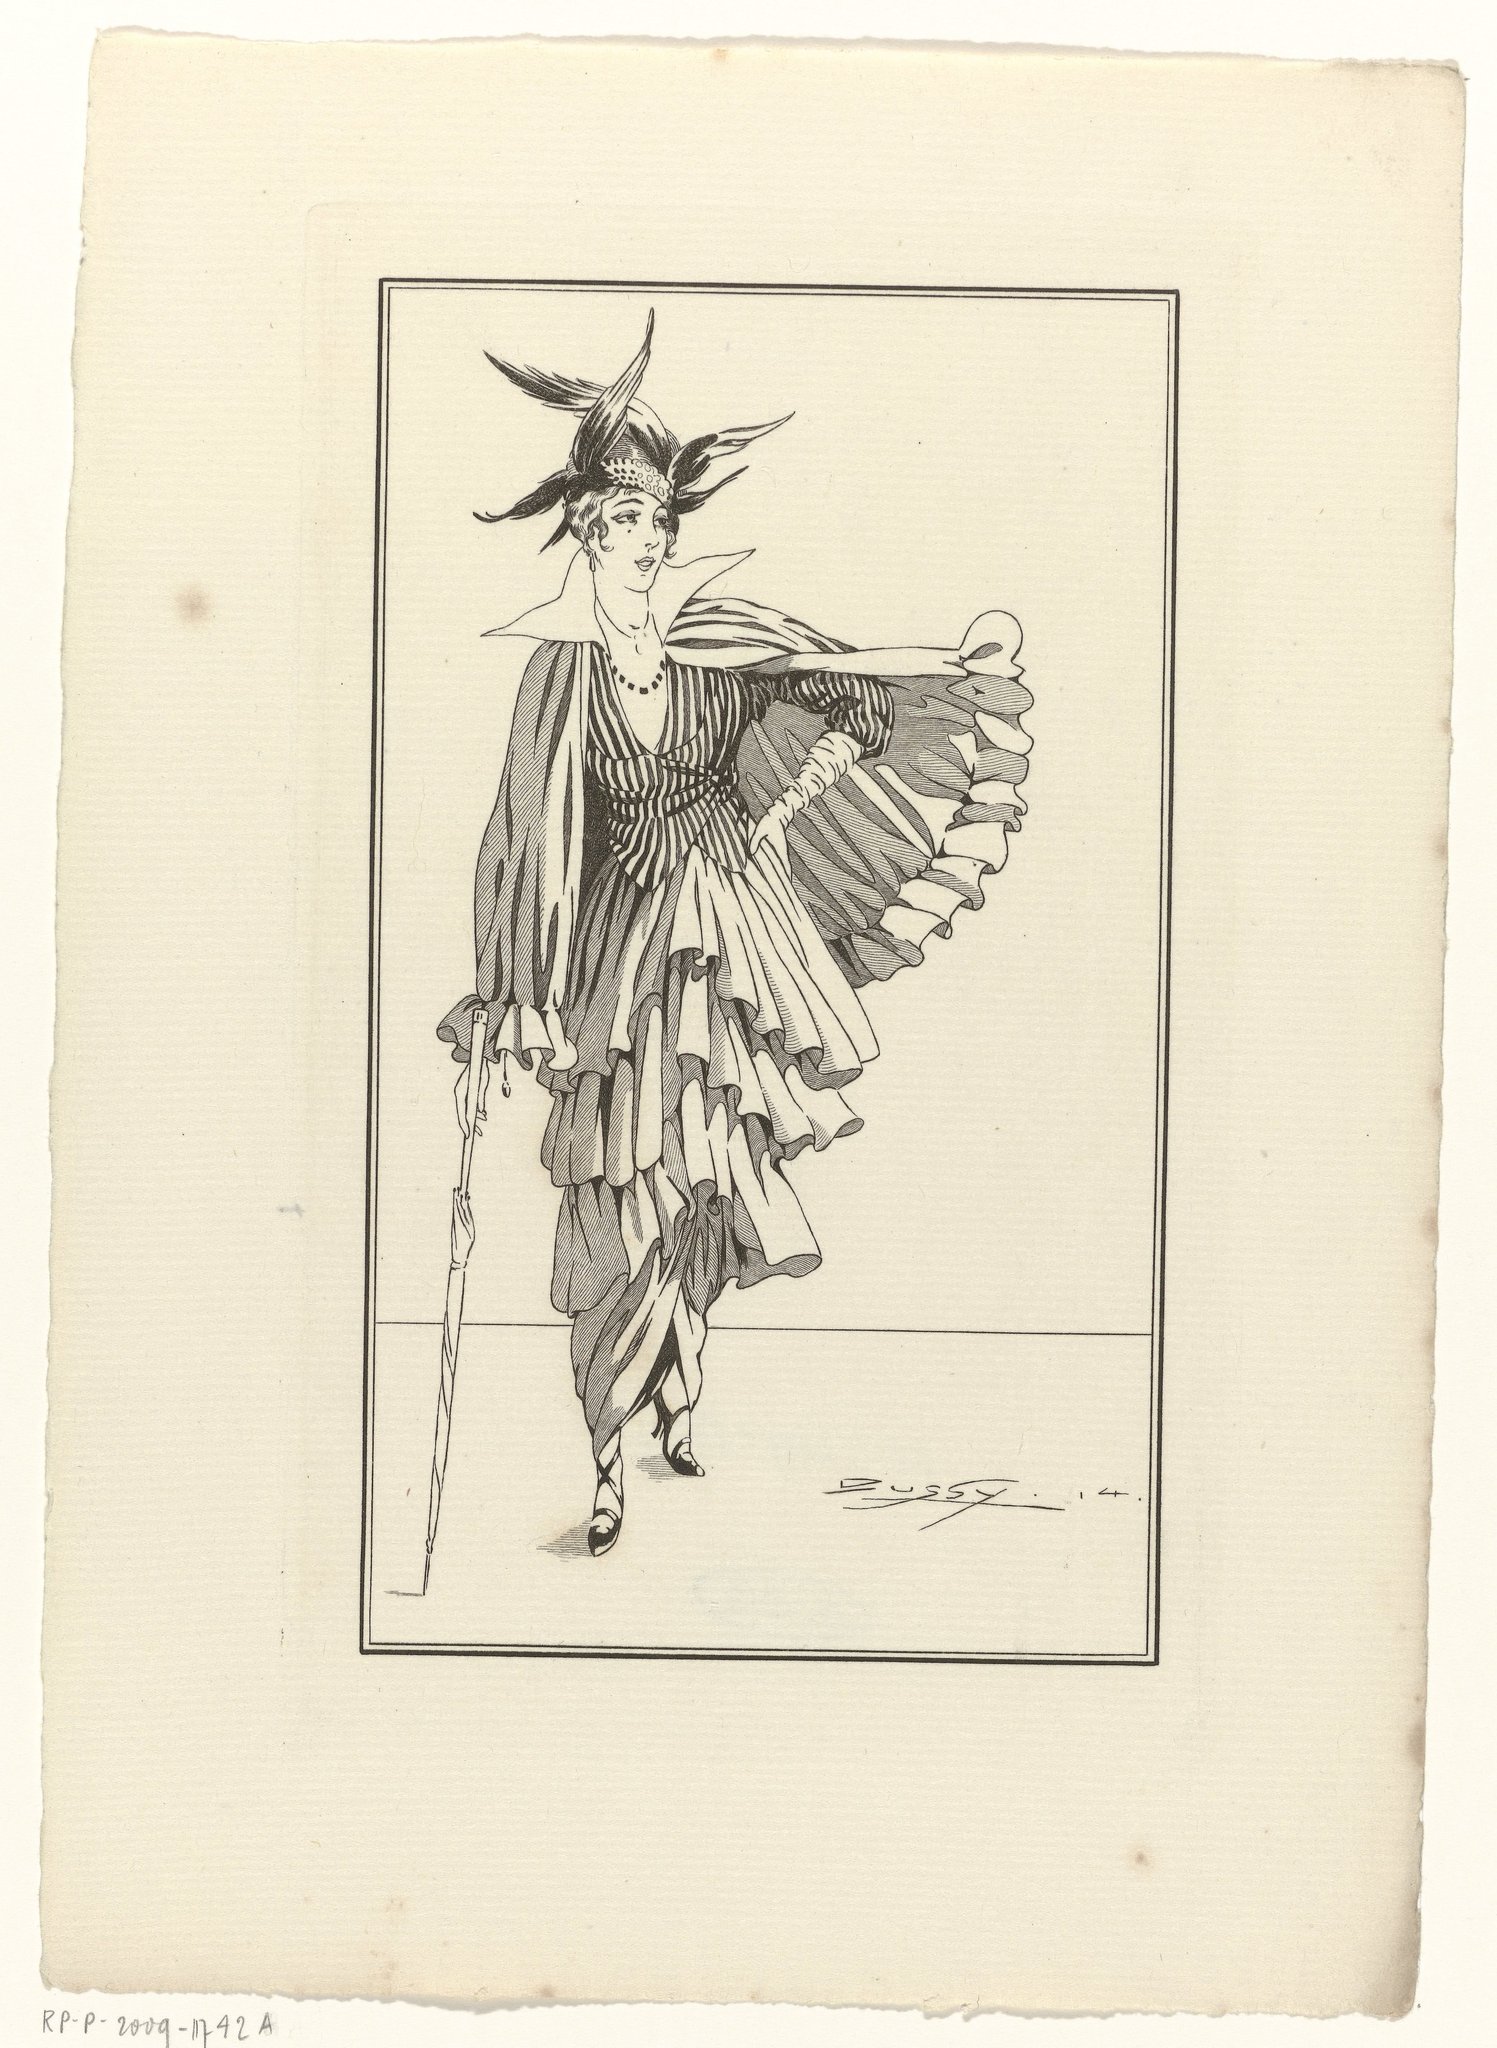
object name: fashion print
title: Journal des Dames et des Modes, Costumes Parisiens, 1914, No. 175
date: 1914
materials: paper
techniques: engraving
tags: walking-stick, staff, cane (+ women's clothes), clothing for the upper part of the body (vest) (+ women's clothes), cape (+ women's clothes), fashion plates, head-gear: hat (+ women's clothes), dress, gown (+ women's clothes)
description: Vrouw in een jurk en cape van blauwe crêpe de chine. Vest van 'velours pékiné'. Proefdruk van een prent uit het modetijdschrift Journal des Dames et des Modes (1912-1914).